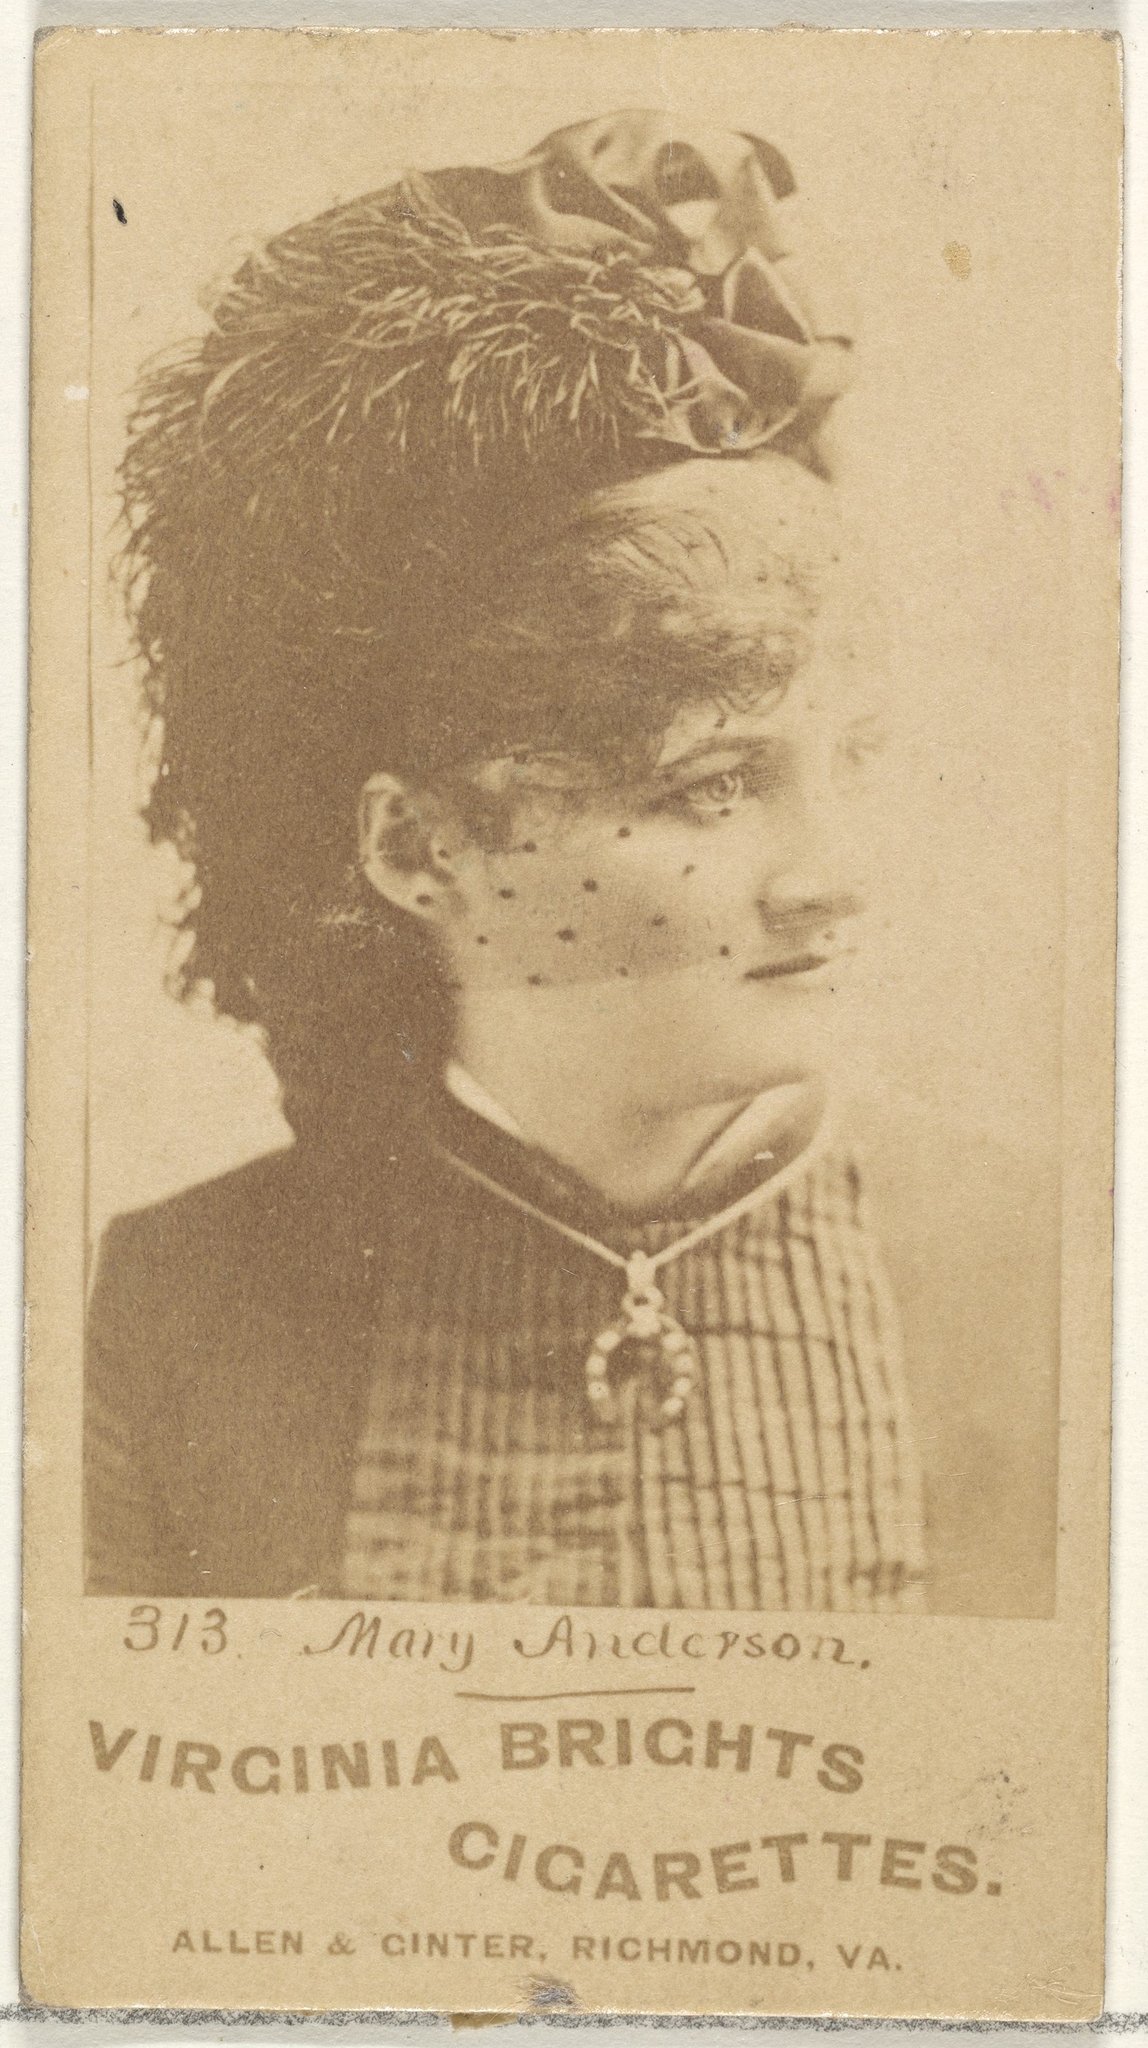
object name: photograph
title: Card 313, Mary Anderson, from the Actors and Actresses series (N45, Type 1) for Virginia Brights Cigarettes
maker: allen & ginter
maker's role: publisher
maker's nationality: american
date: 1888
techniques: albumen silver print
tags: portraits,women,actresses